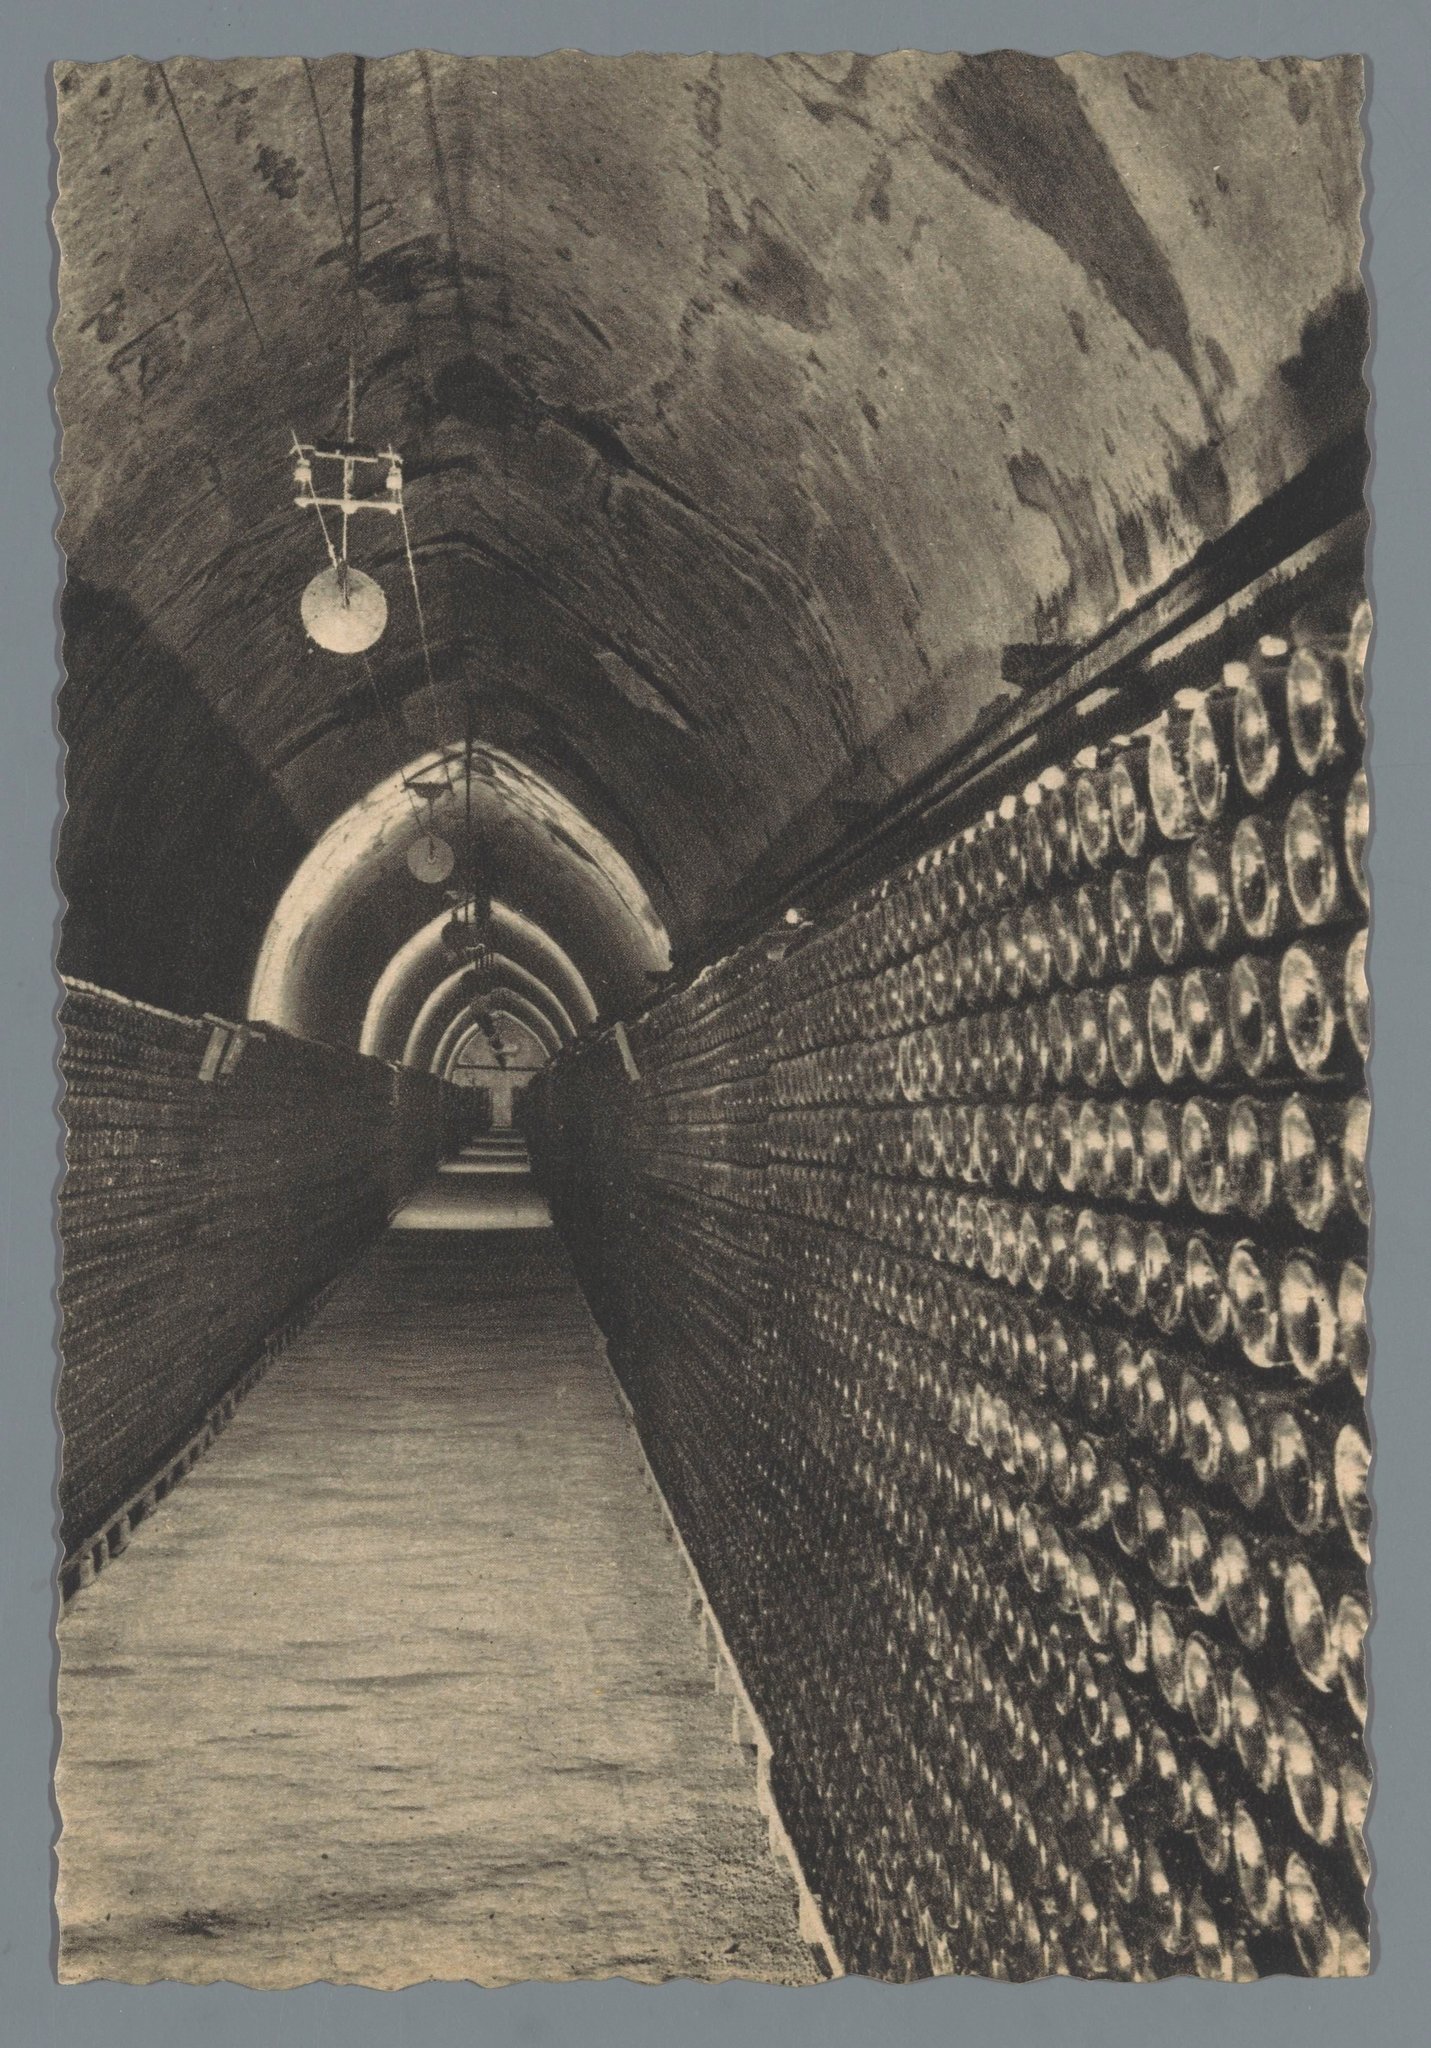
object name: ansichtkaart, prentbriefkaart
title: Une galerie de vins sur lattes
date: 1930-1960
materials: paper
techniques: rotogravure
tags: wine-cellar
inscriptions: inscription: ‘Champagne Pommery & Greno - Reims’